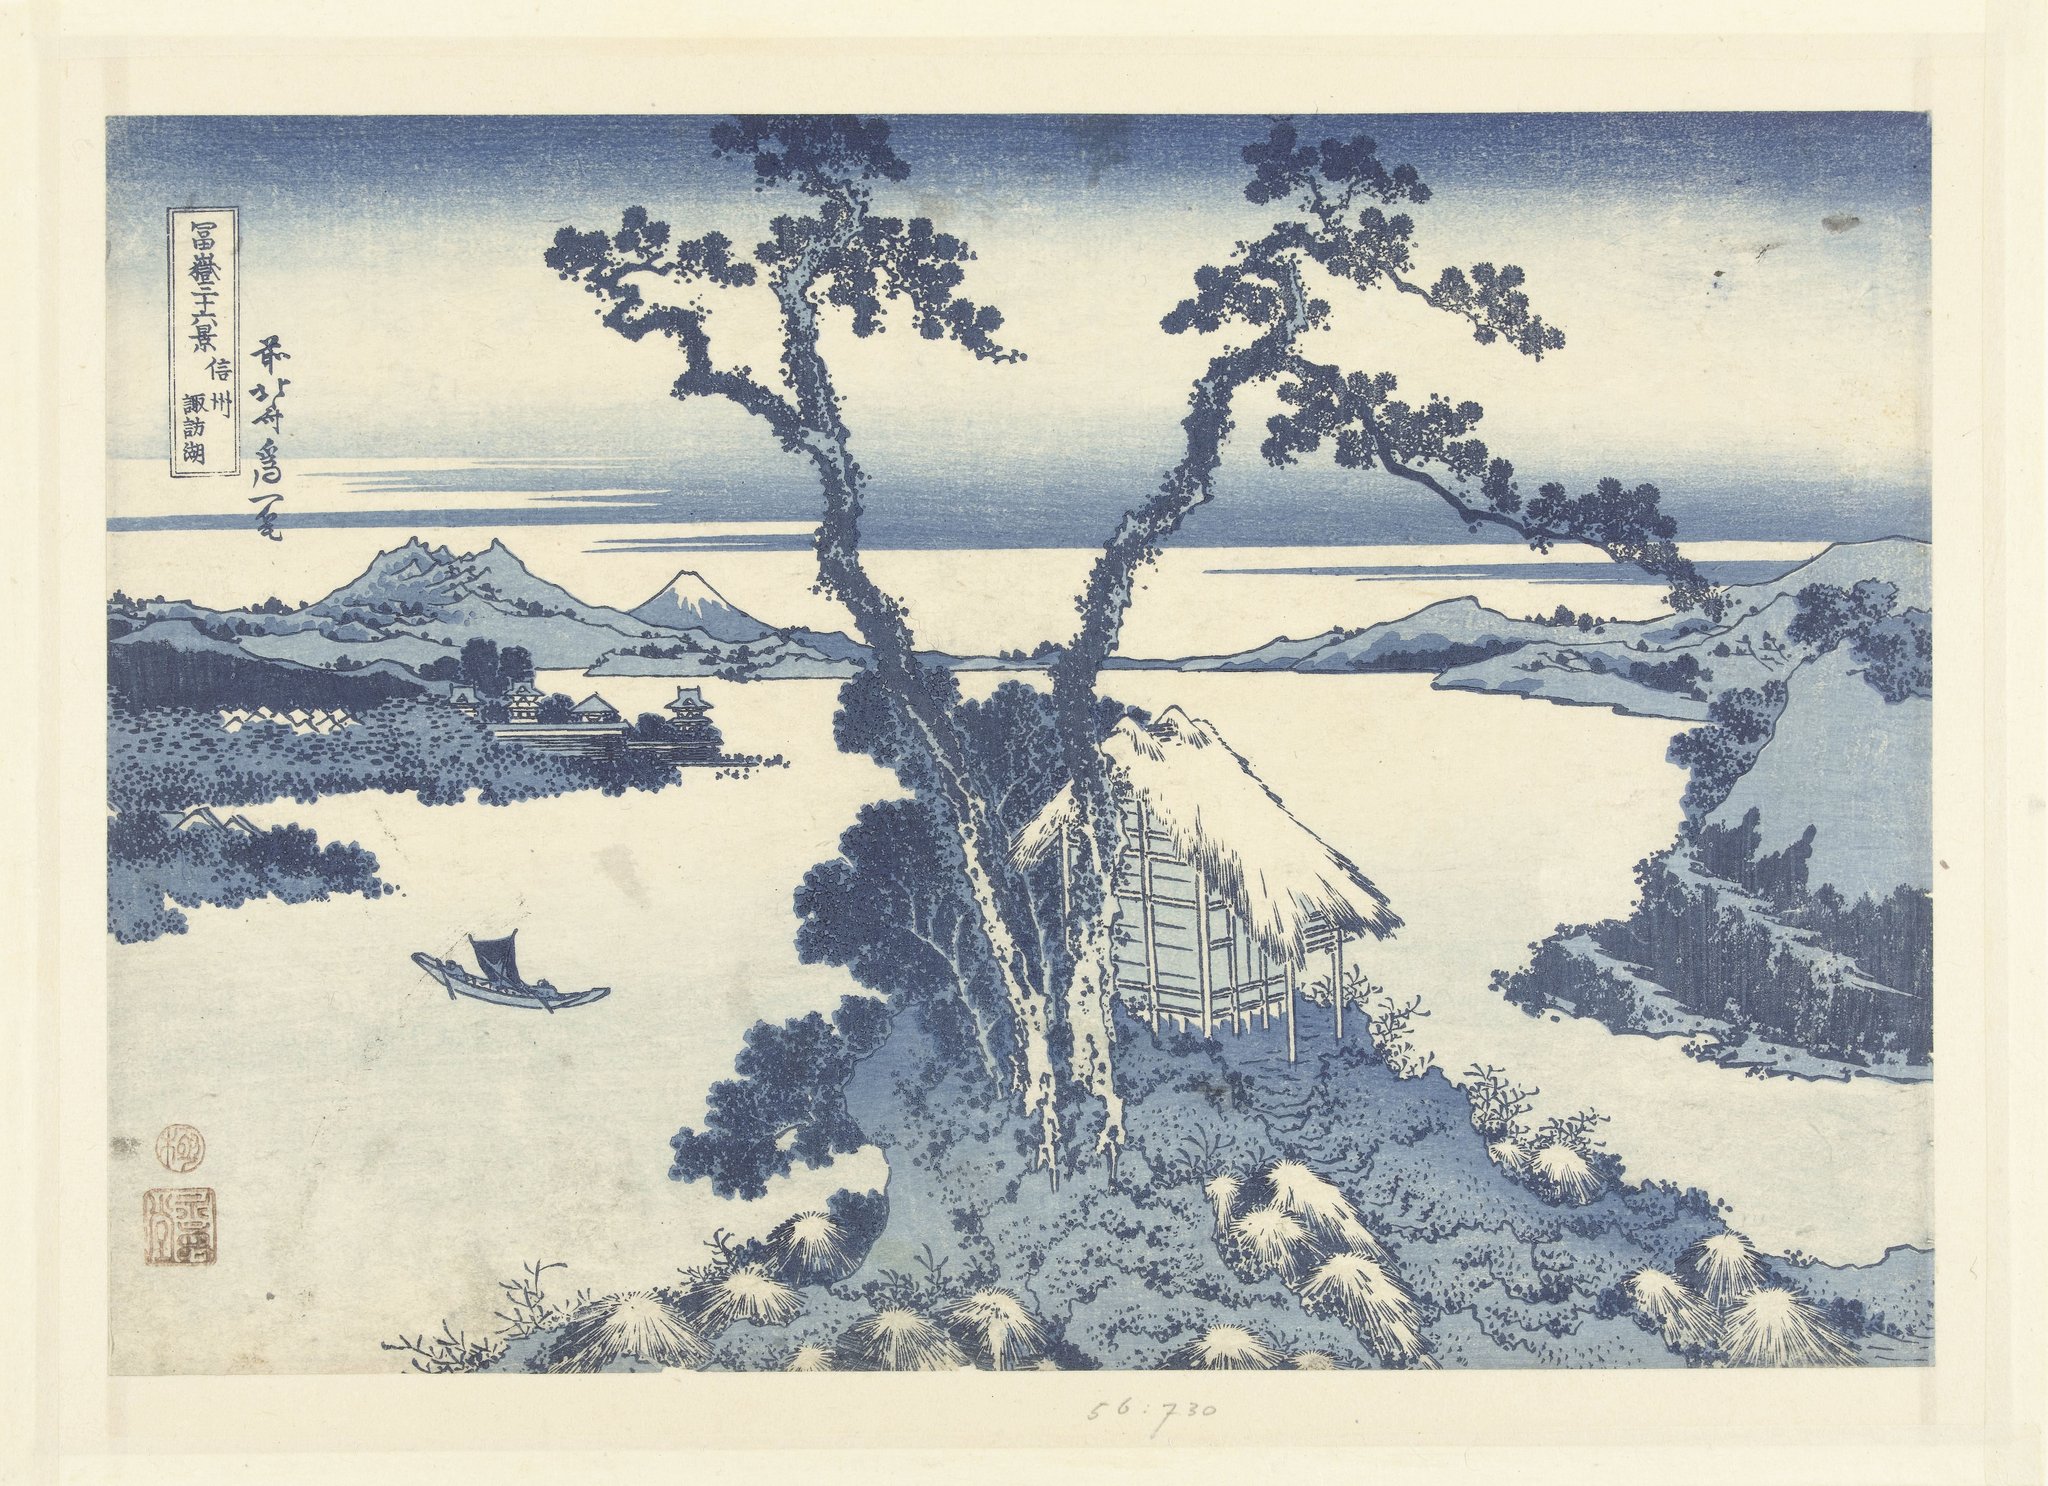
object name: print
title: Fugaku sanjurokkei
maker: katsushika hokusai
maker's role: draughtsman, print maker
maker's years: 1760-1849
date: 1829-1833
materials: paper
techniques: woodcut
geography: japan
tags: lake, temple, shrine ~ non-christian religions, mountains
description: Gezicht over het Suwa meer met de berg Fuji op de achtergrond; op de voorgrond een rots waarop een heiligdom en twee bomen.